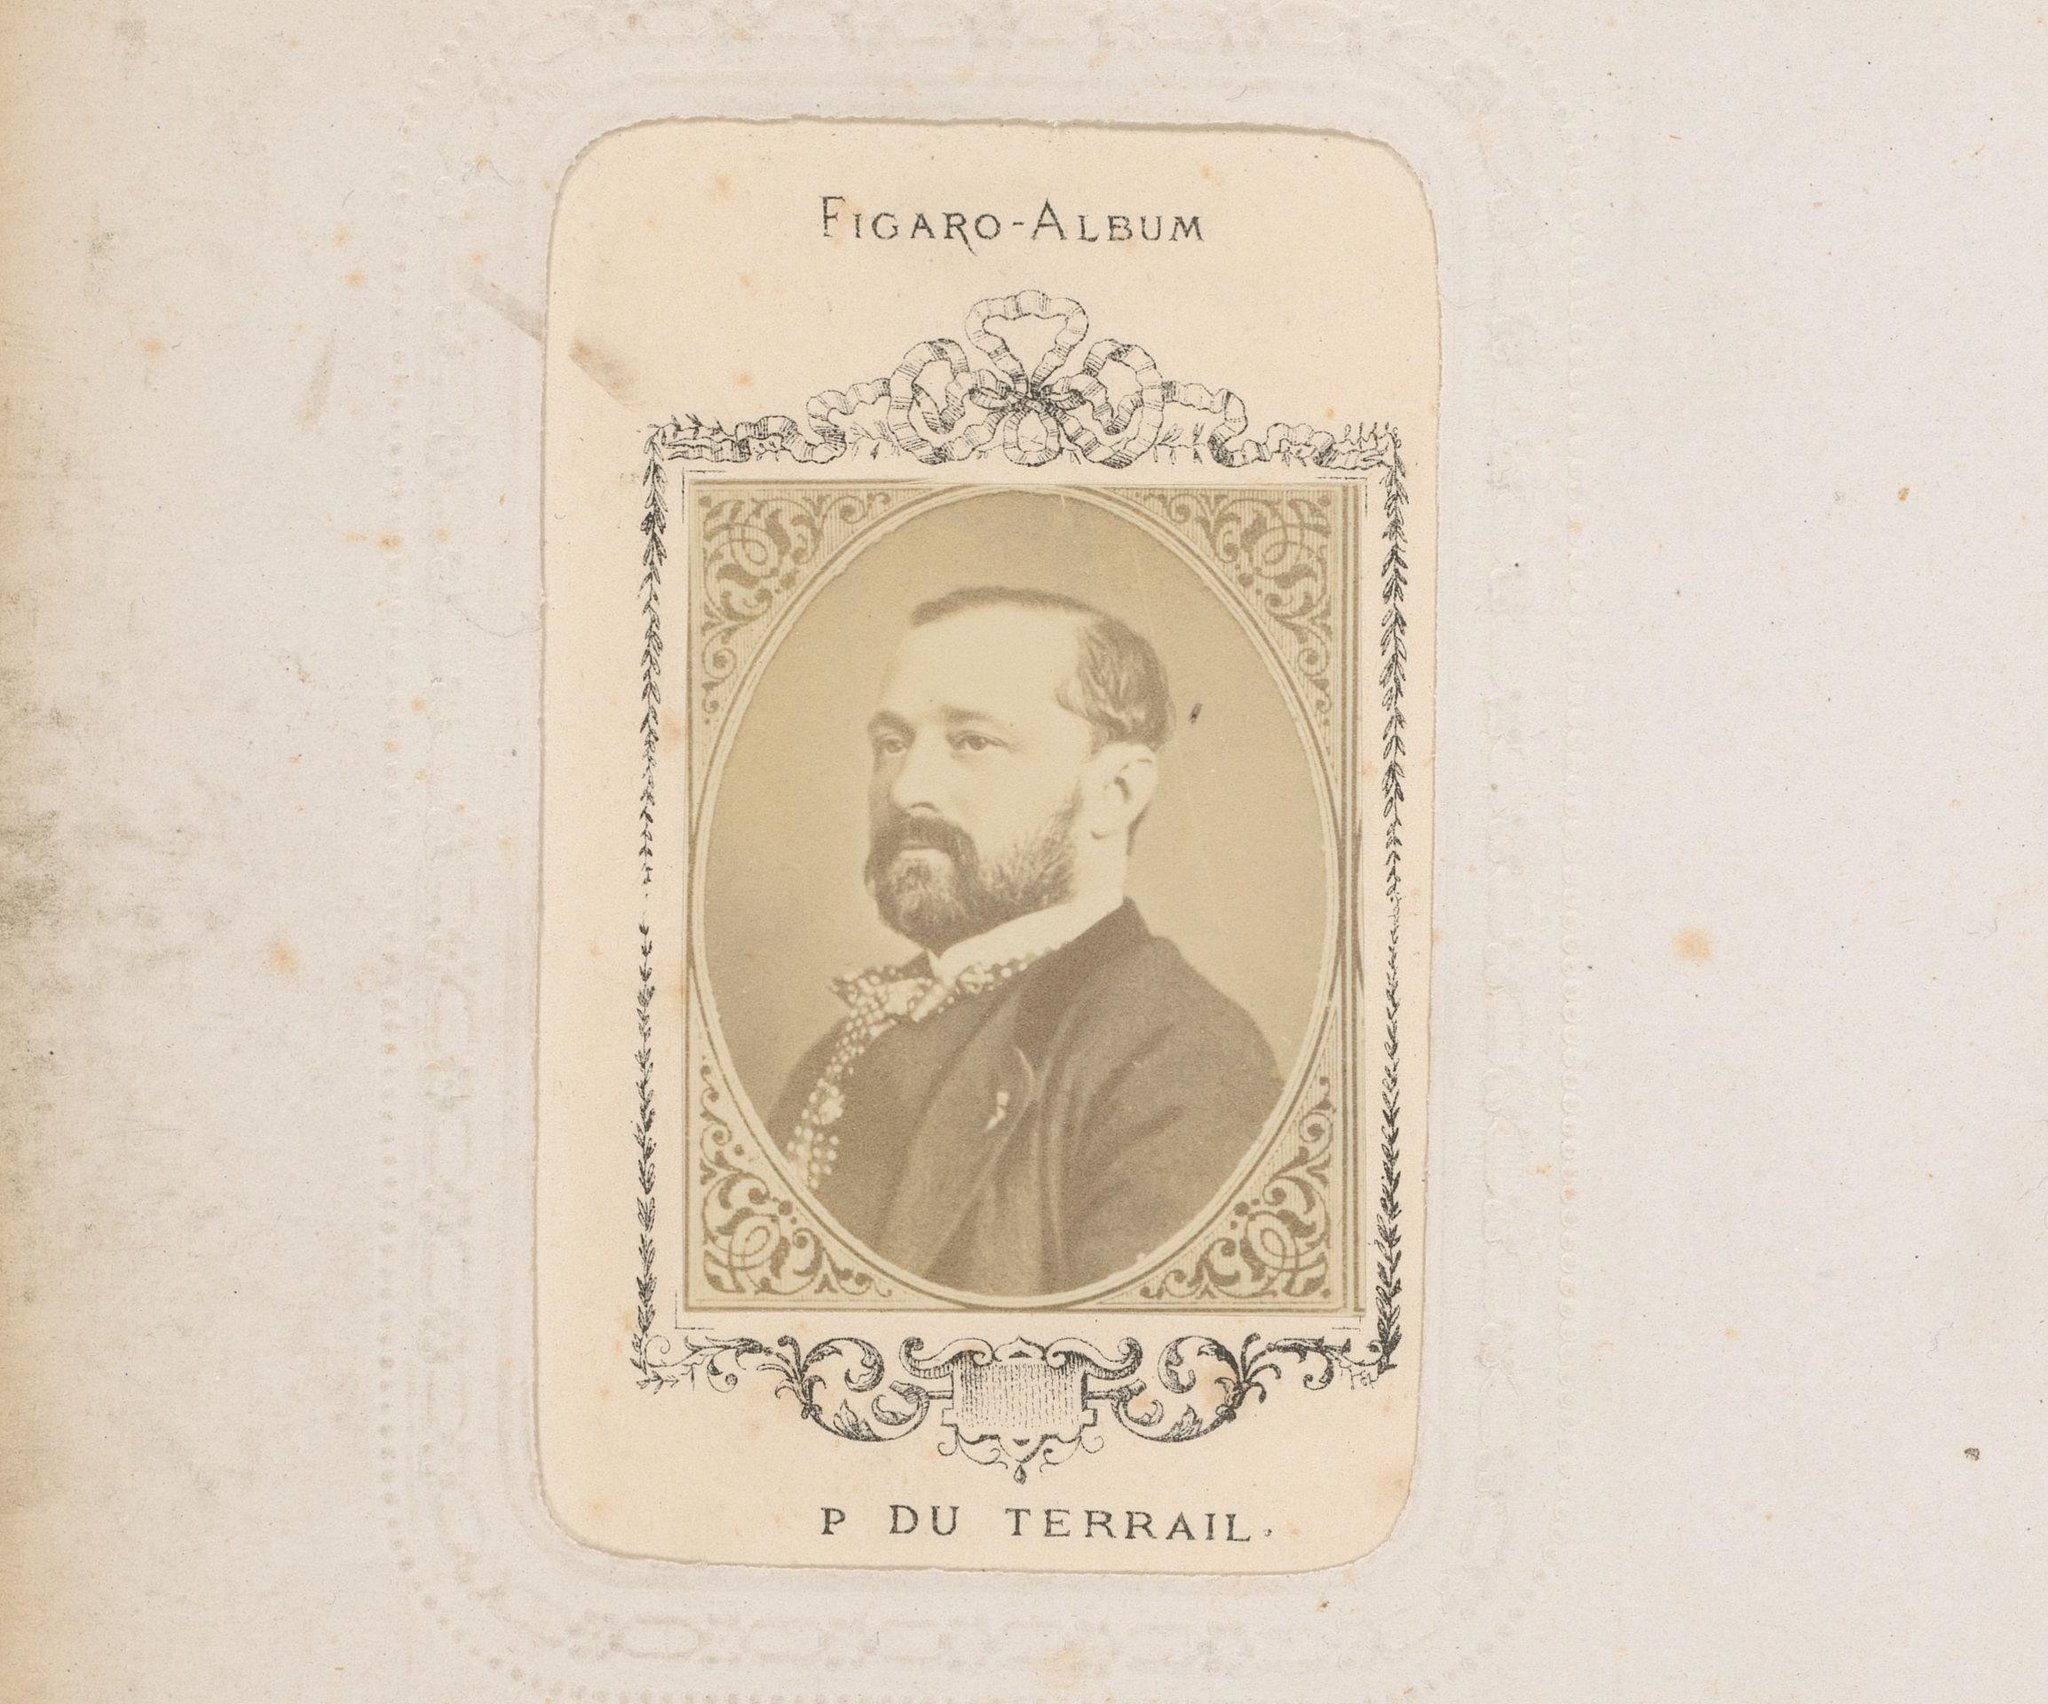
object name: carte de visite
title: Fotoreproductie van een portret van Pierre-Alexis Ponson du Terrail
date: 1860-1900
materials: cardboard, photographic support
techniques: albumen print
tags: historical persons, portrait of a writer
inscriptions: inscription: ‘Figaro-Album/ P. du Terrail/ Liébert Phot.’